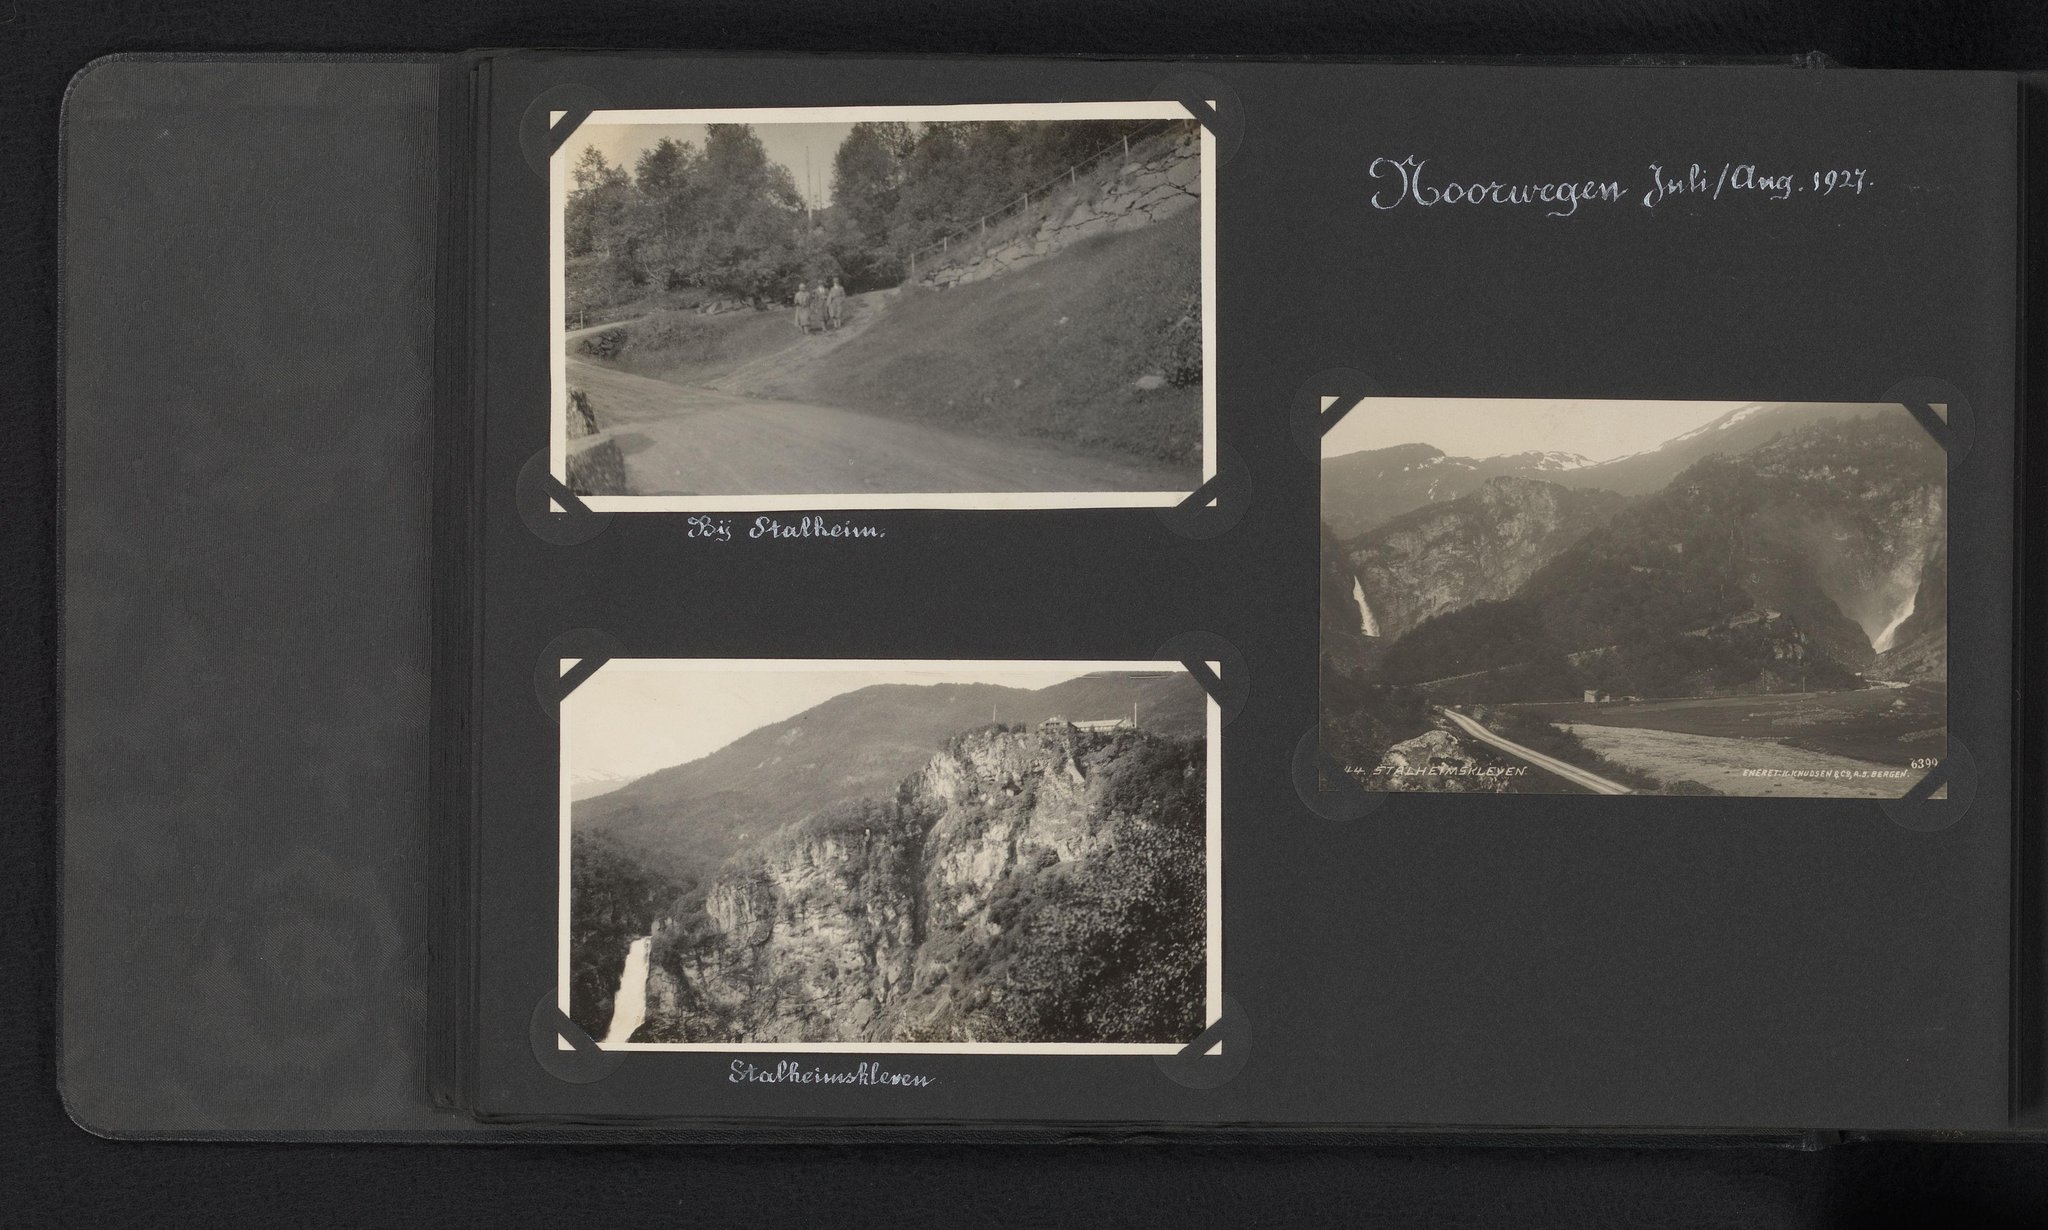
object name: photograph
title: Noorwegen Juli/Aug. 1927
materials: paper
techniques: gelatin silver print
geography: norway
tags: the hague, caroline louise van den berg-van den berg, amsterdam, carel frederik van den berg (cay), frank willem van den berg (1912-1998), the family travelling, on holiday, mountains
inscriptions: inscription: ‘Bij Stalheim’, inscription: ‘Stalheimskleven’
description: Deze foto's maken deel uit van een album.